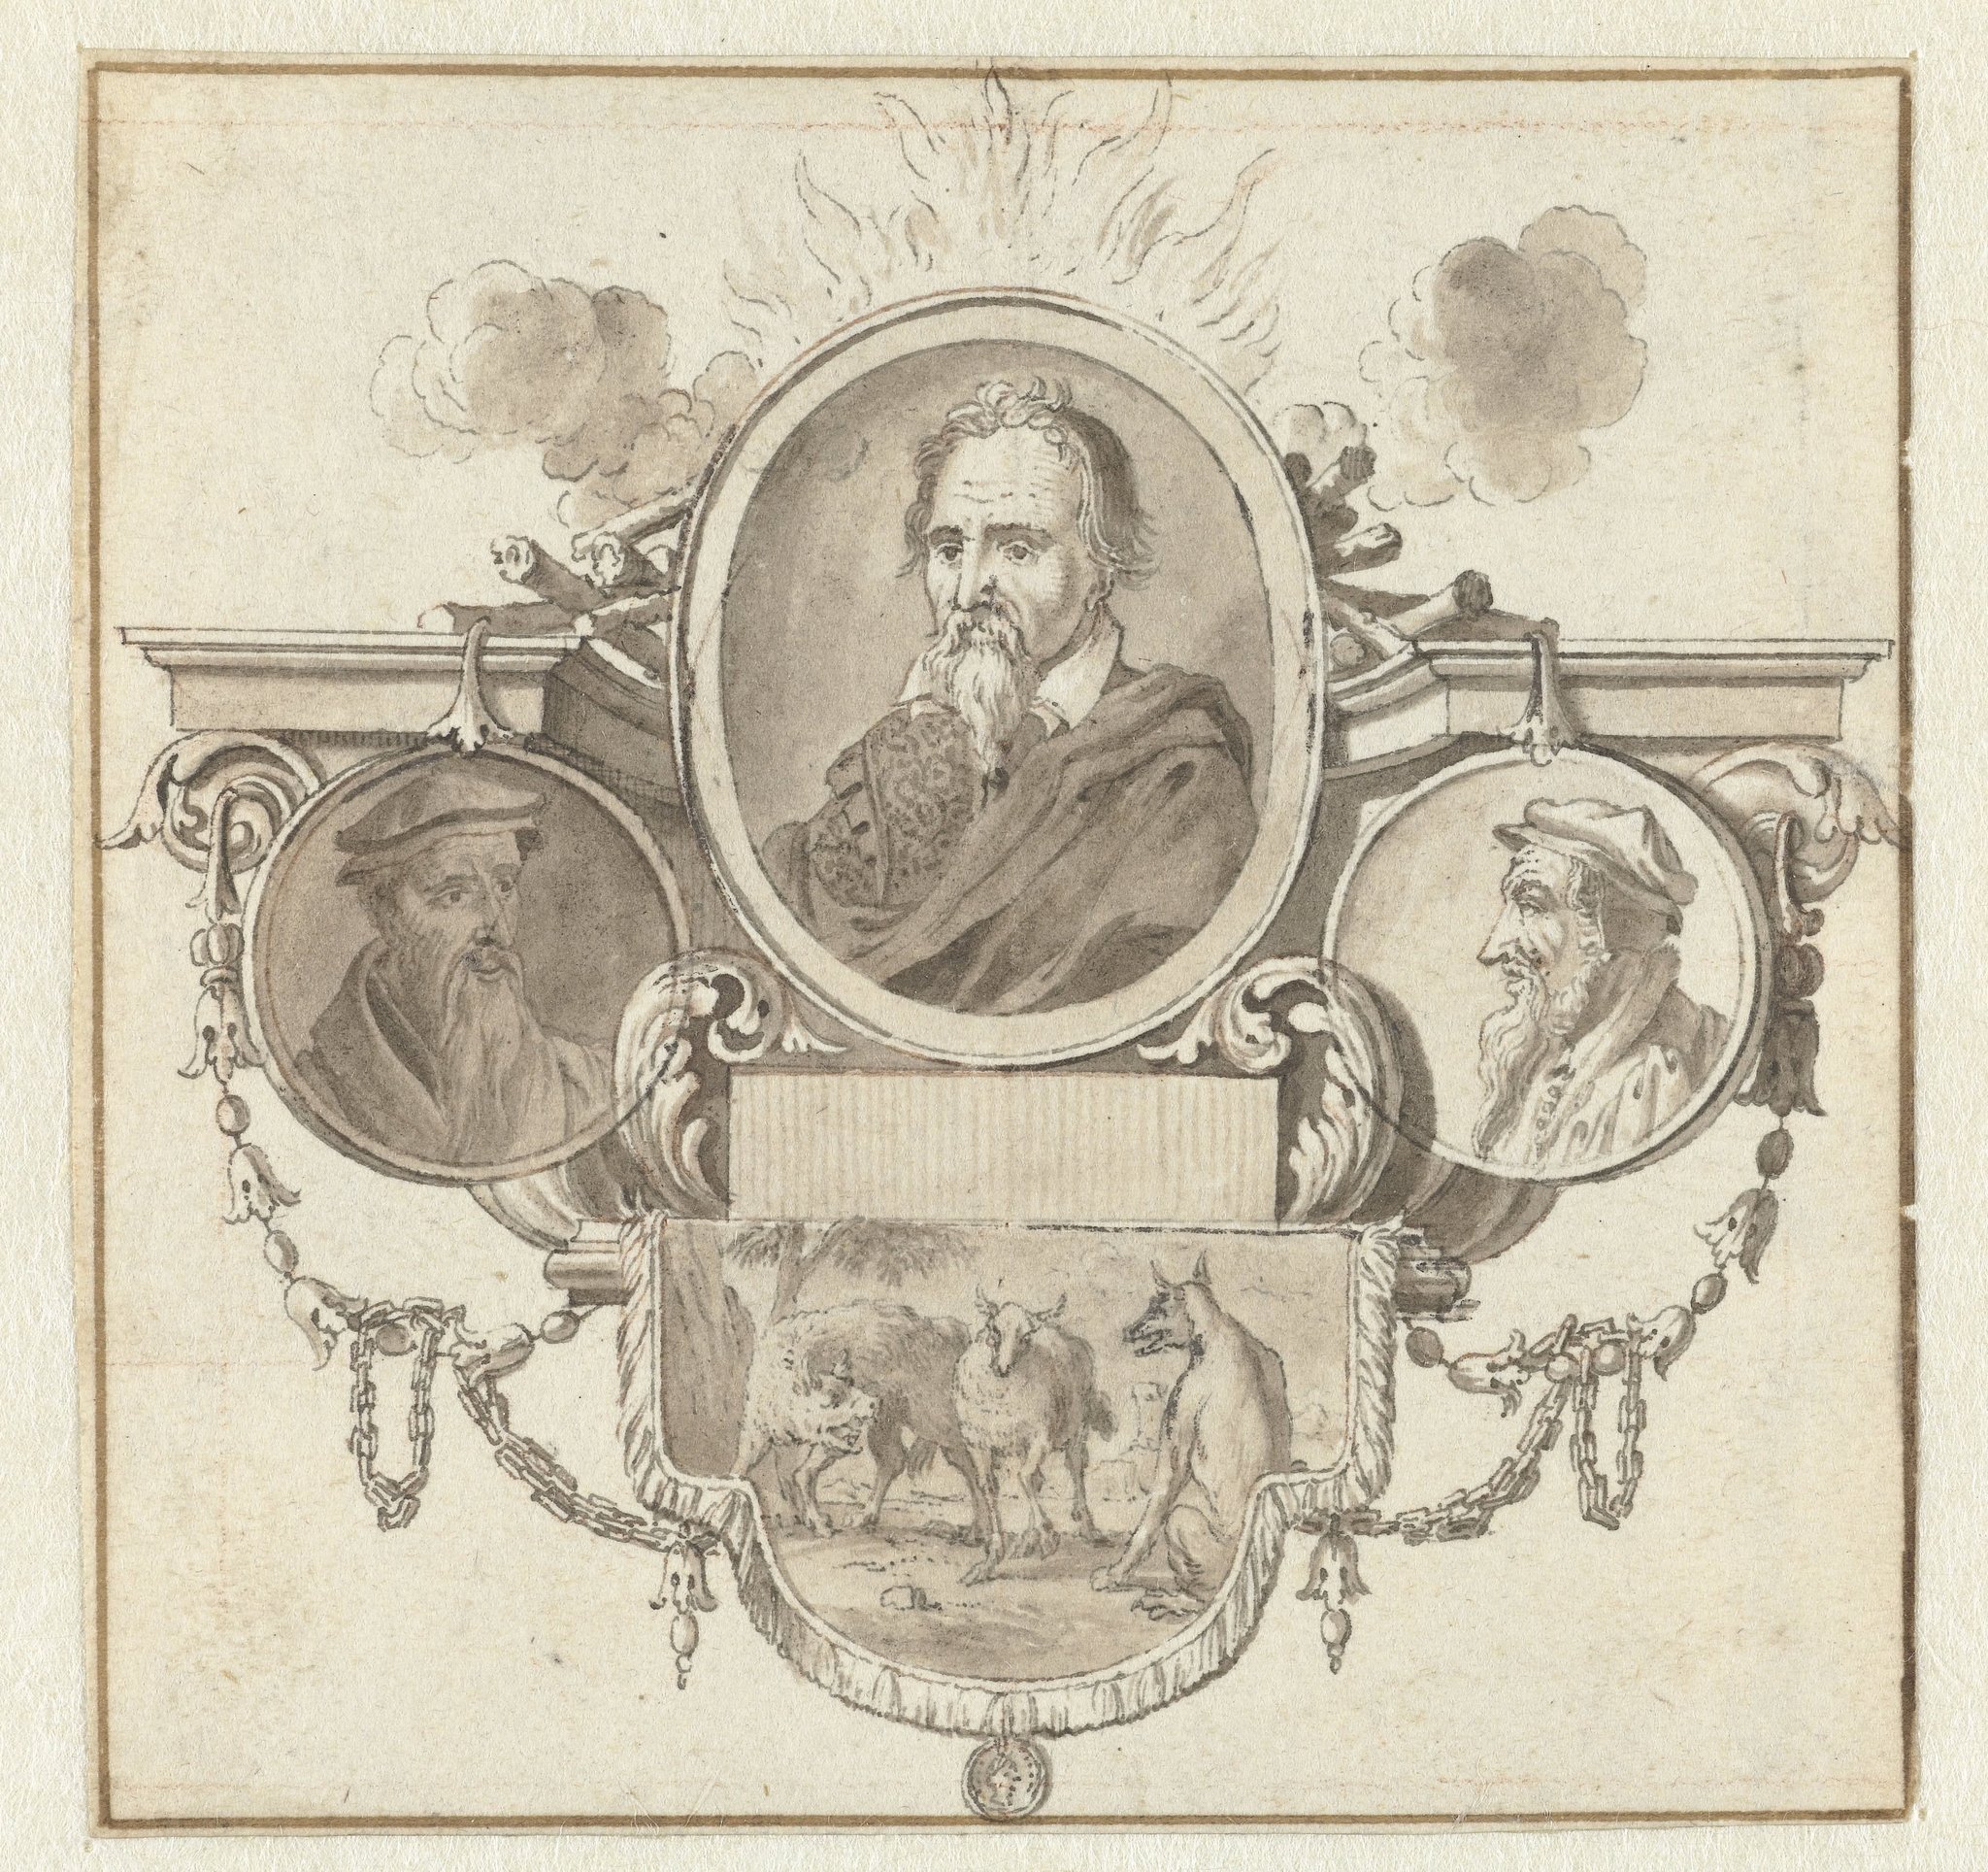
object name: drawing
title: Portret van een theoloog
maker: jan goeree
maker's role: draughtsman, print maker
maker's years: 1670-1731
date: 1680-1731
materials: chalk, ink, paper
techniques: brush, pen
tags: anonymous historical person portrayed (+ historical person or scene in allegorical or symbolic frame or setting; or with allegorical or symbolic accessories)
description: Portretmedaillon van een theoloog; boven zijn hoofd brandt een vuurtje. Onder twee andere portretjes en een voorstelling van een schaap bedreigd door twee wolven.